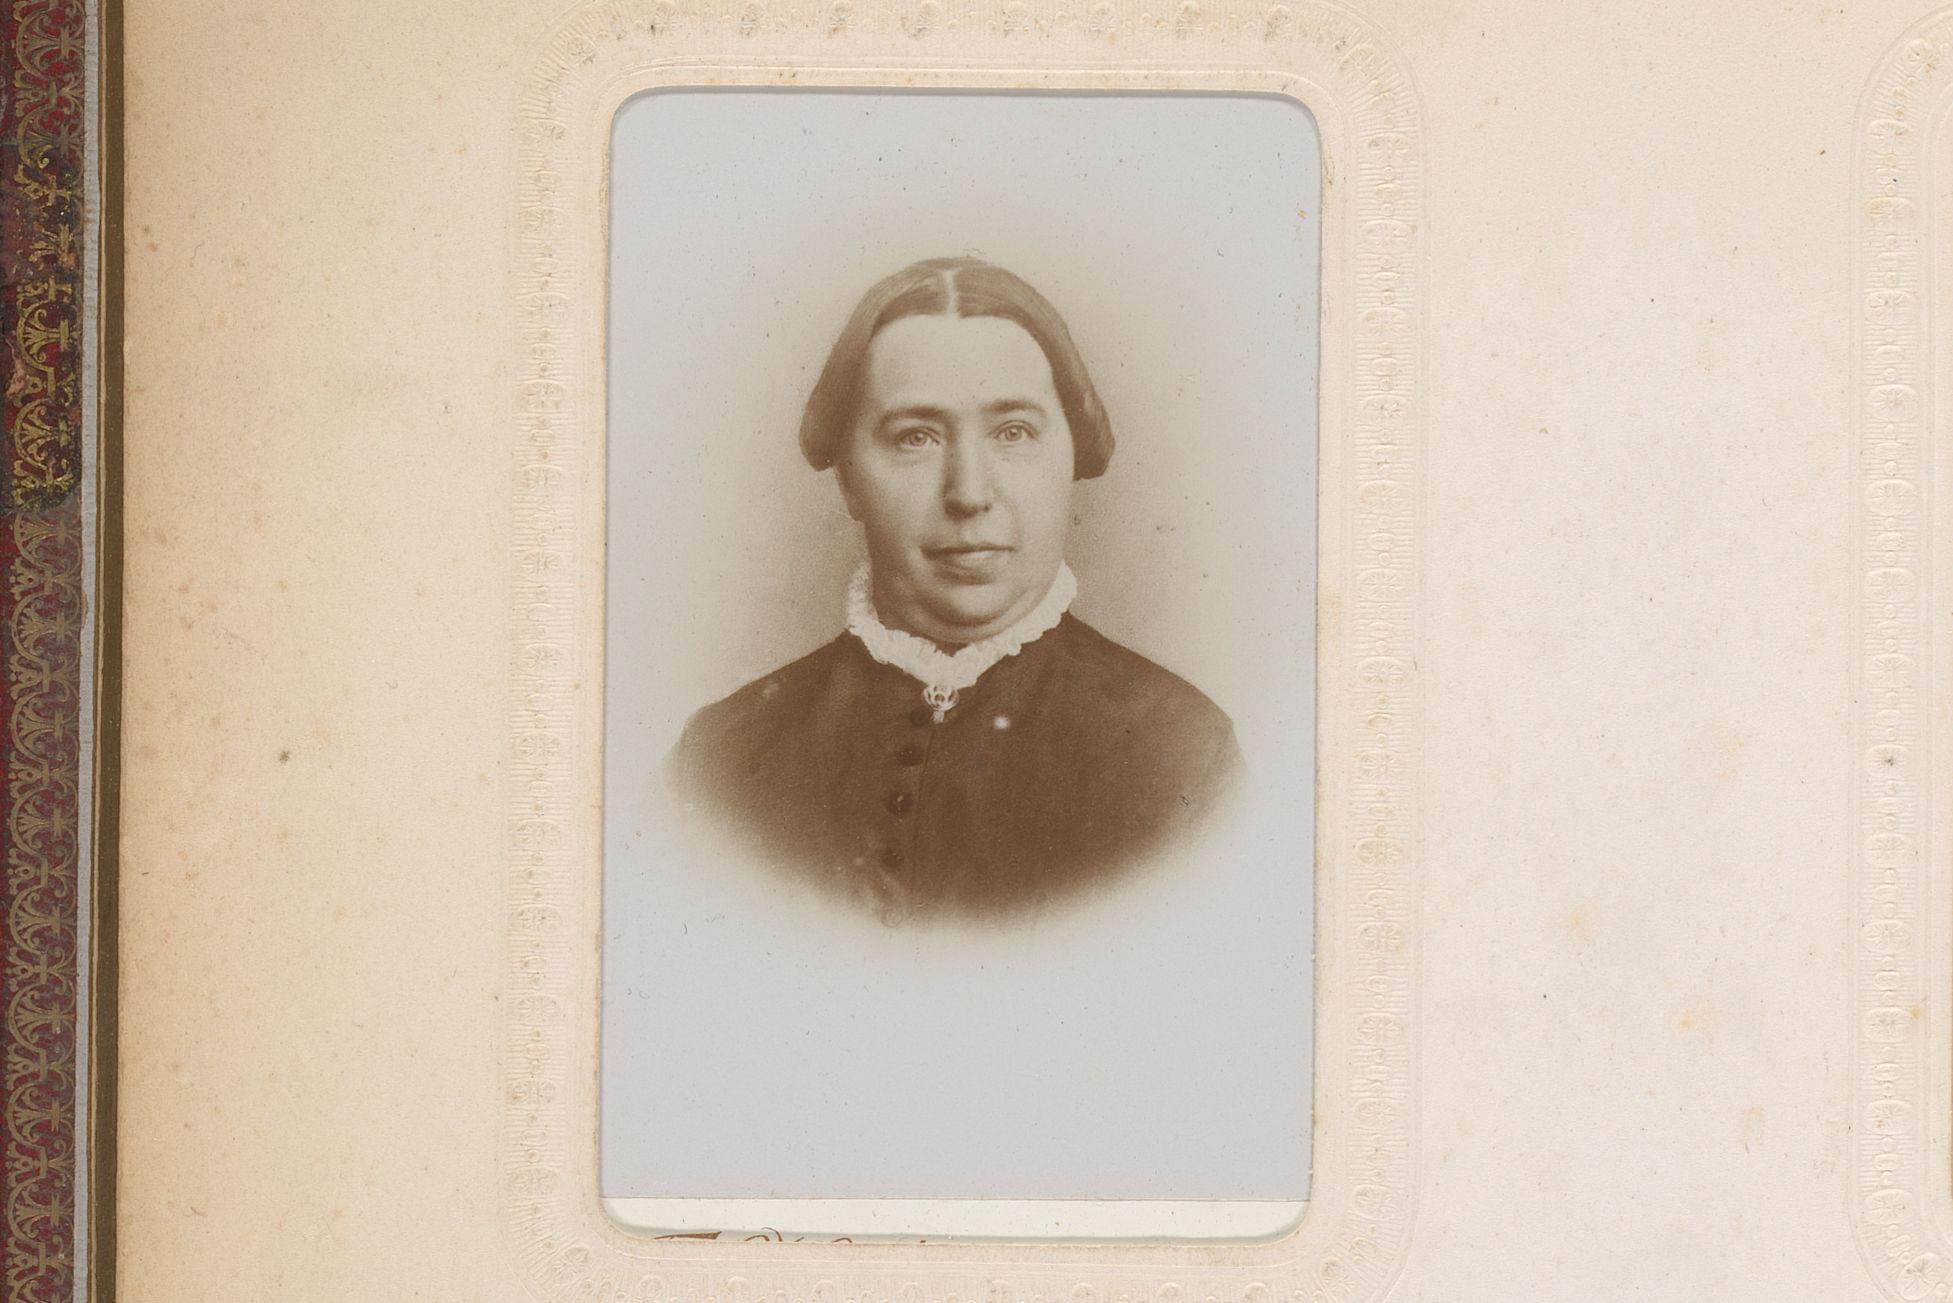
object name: photograph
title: Portret van een vrouw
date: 1881-1901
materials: cardboard, photographic support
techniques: collodion silver print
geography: haarlem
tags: historical persons - bb - woman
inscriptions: inscription: ‘C.F. & L.J. Cordes/ Haarlem’